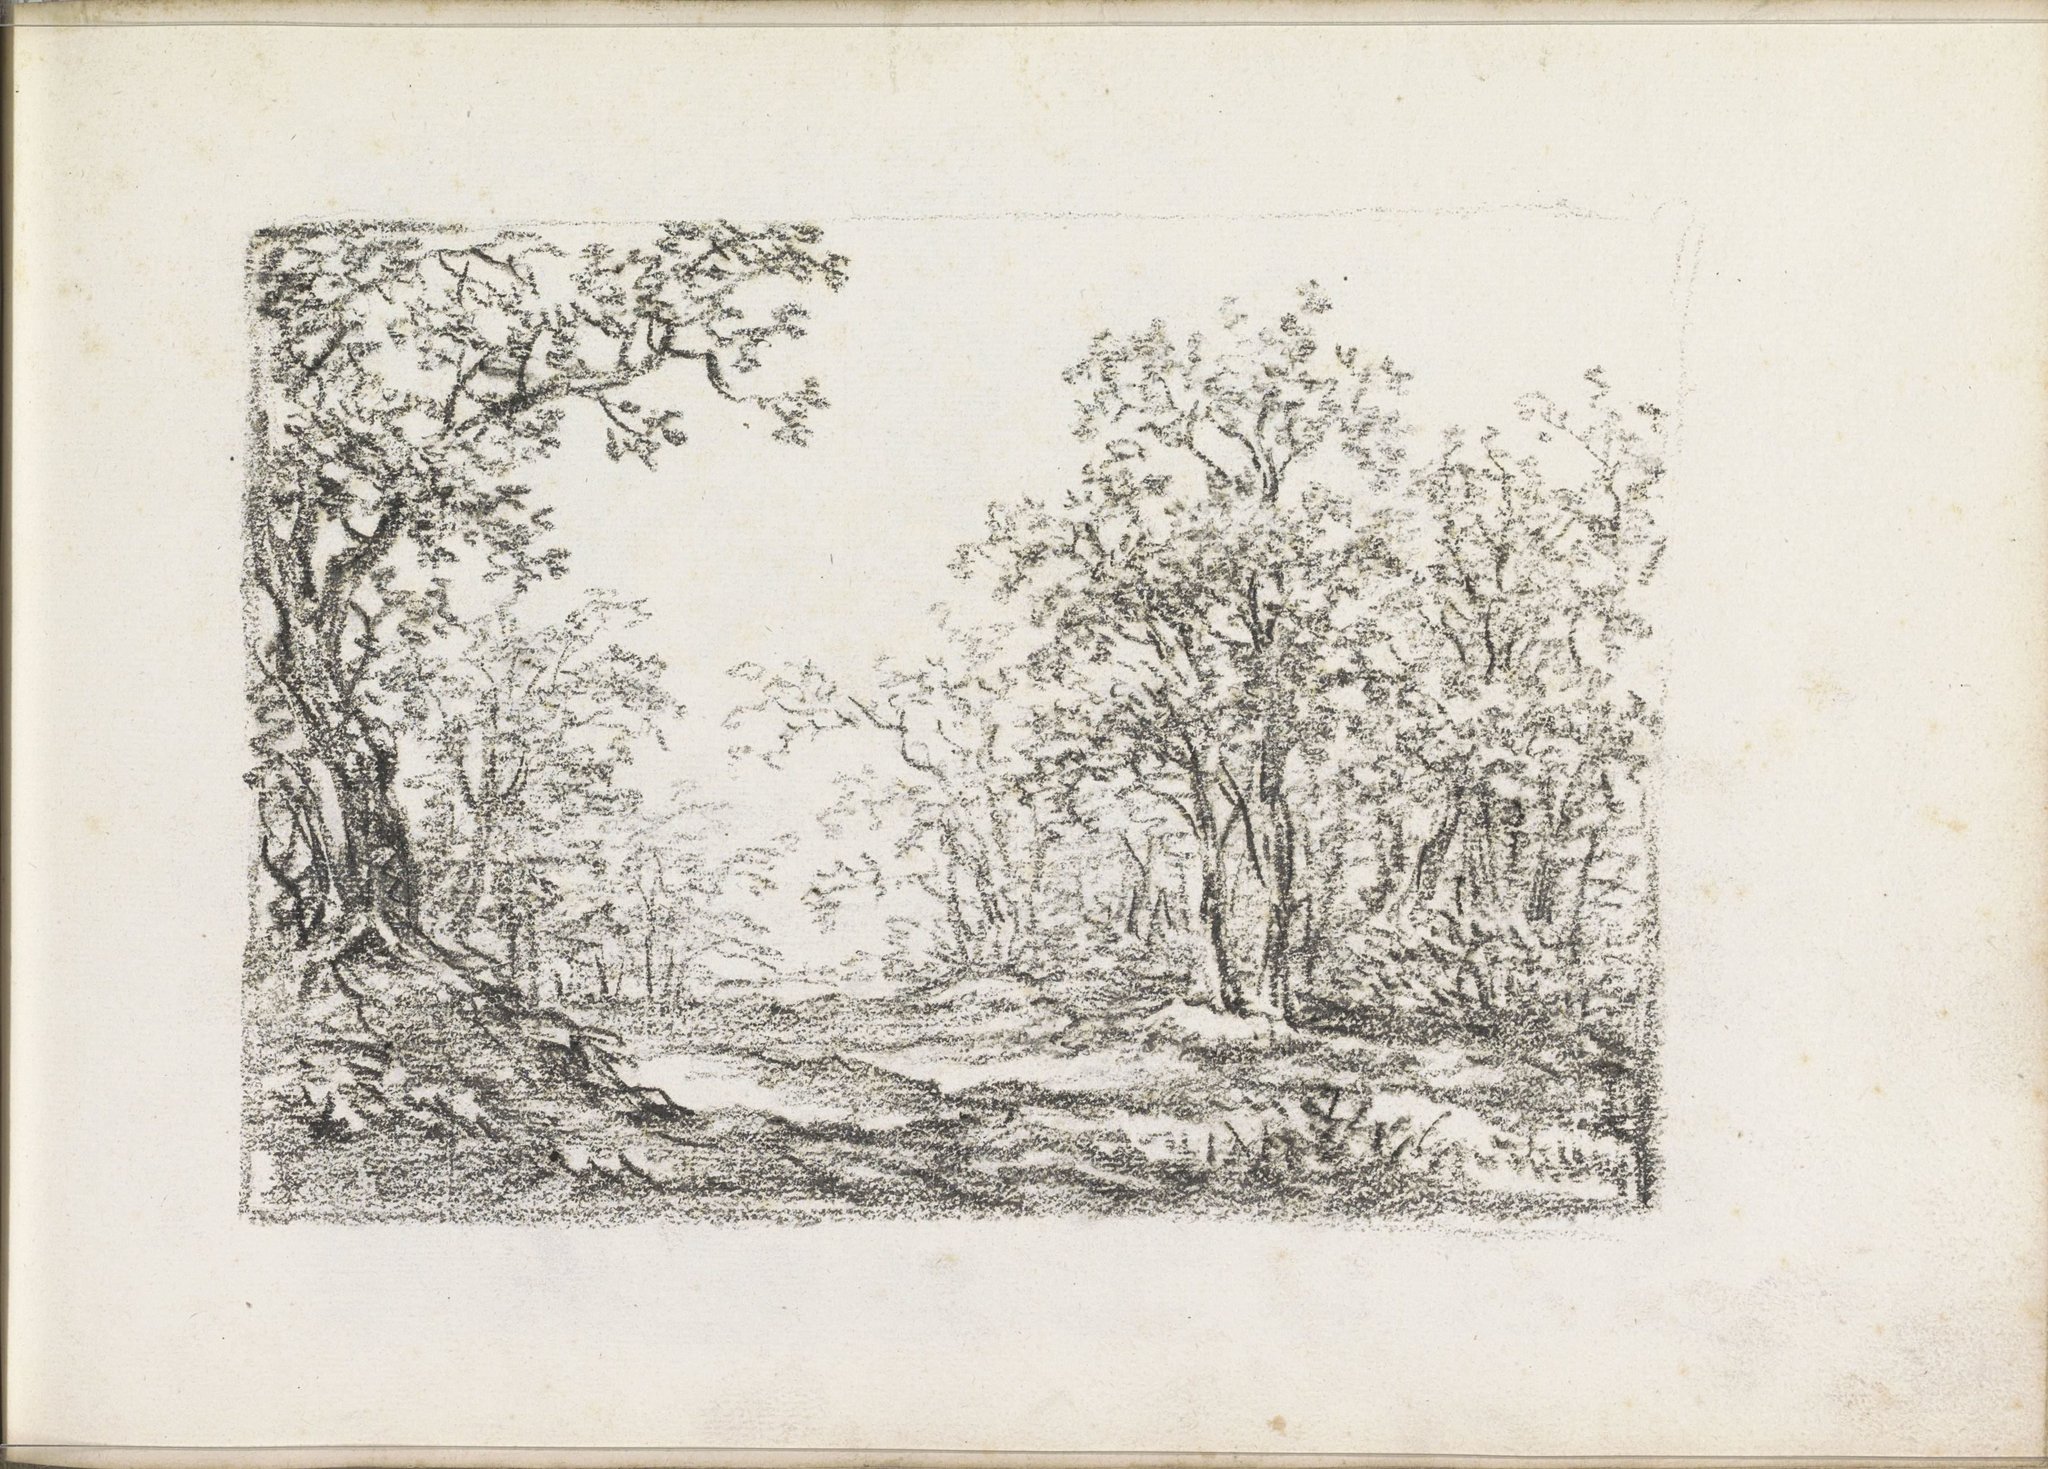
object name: sketchbook leaf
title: Landschap met bomen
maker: andreas schelfhout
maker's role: draughtsman, painter, print maker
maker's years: 1787-1870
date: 1811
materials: chalk, paper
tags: trees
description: Blad 44 recto uit een schetsboek met 75 bladen.